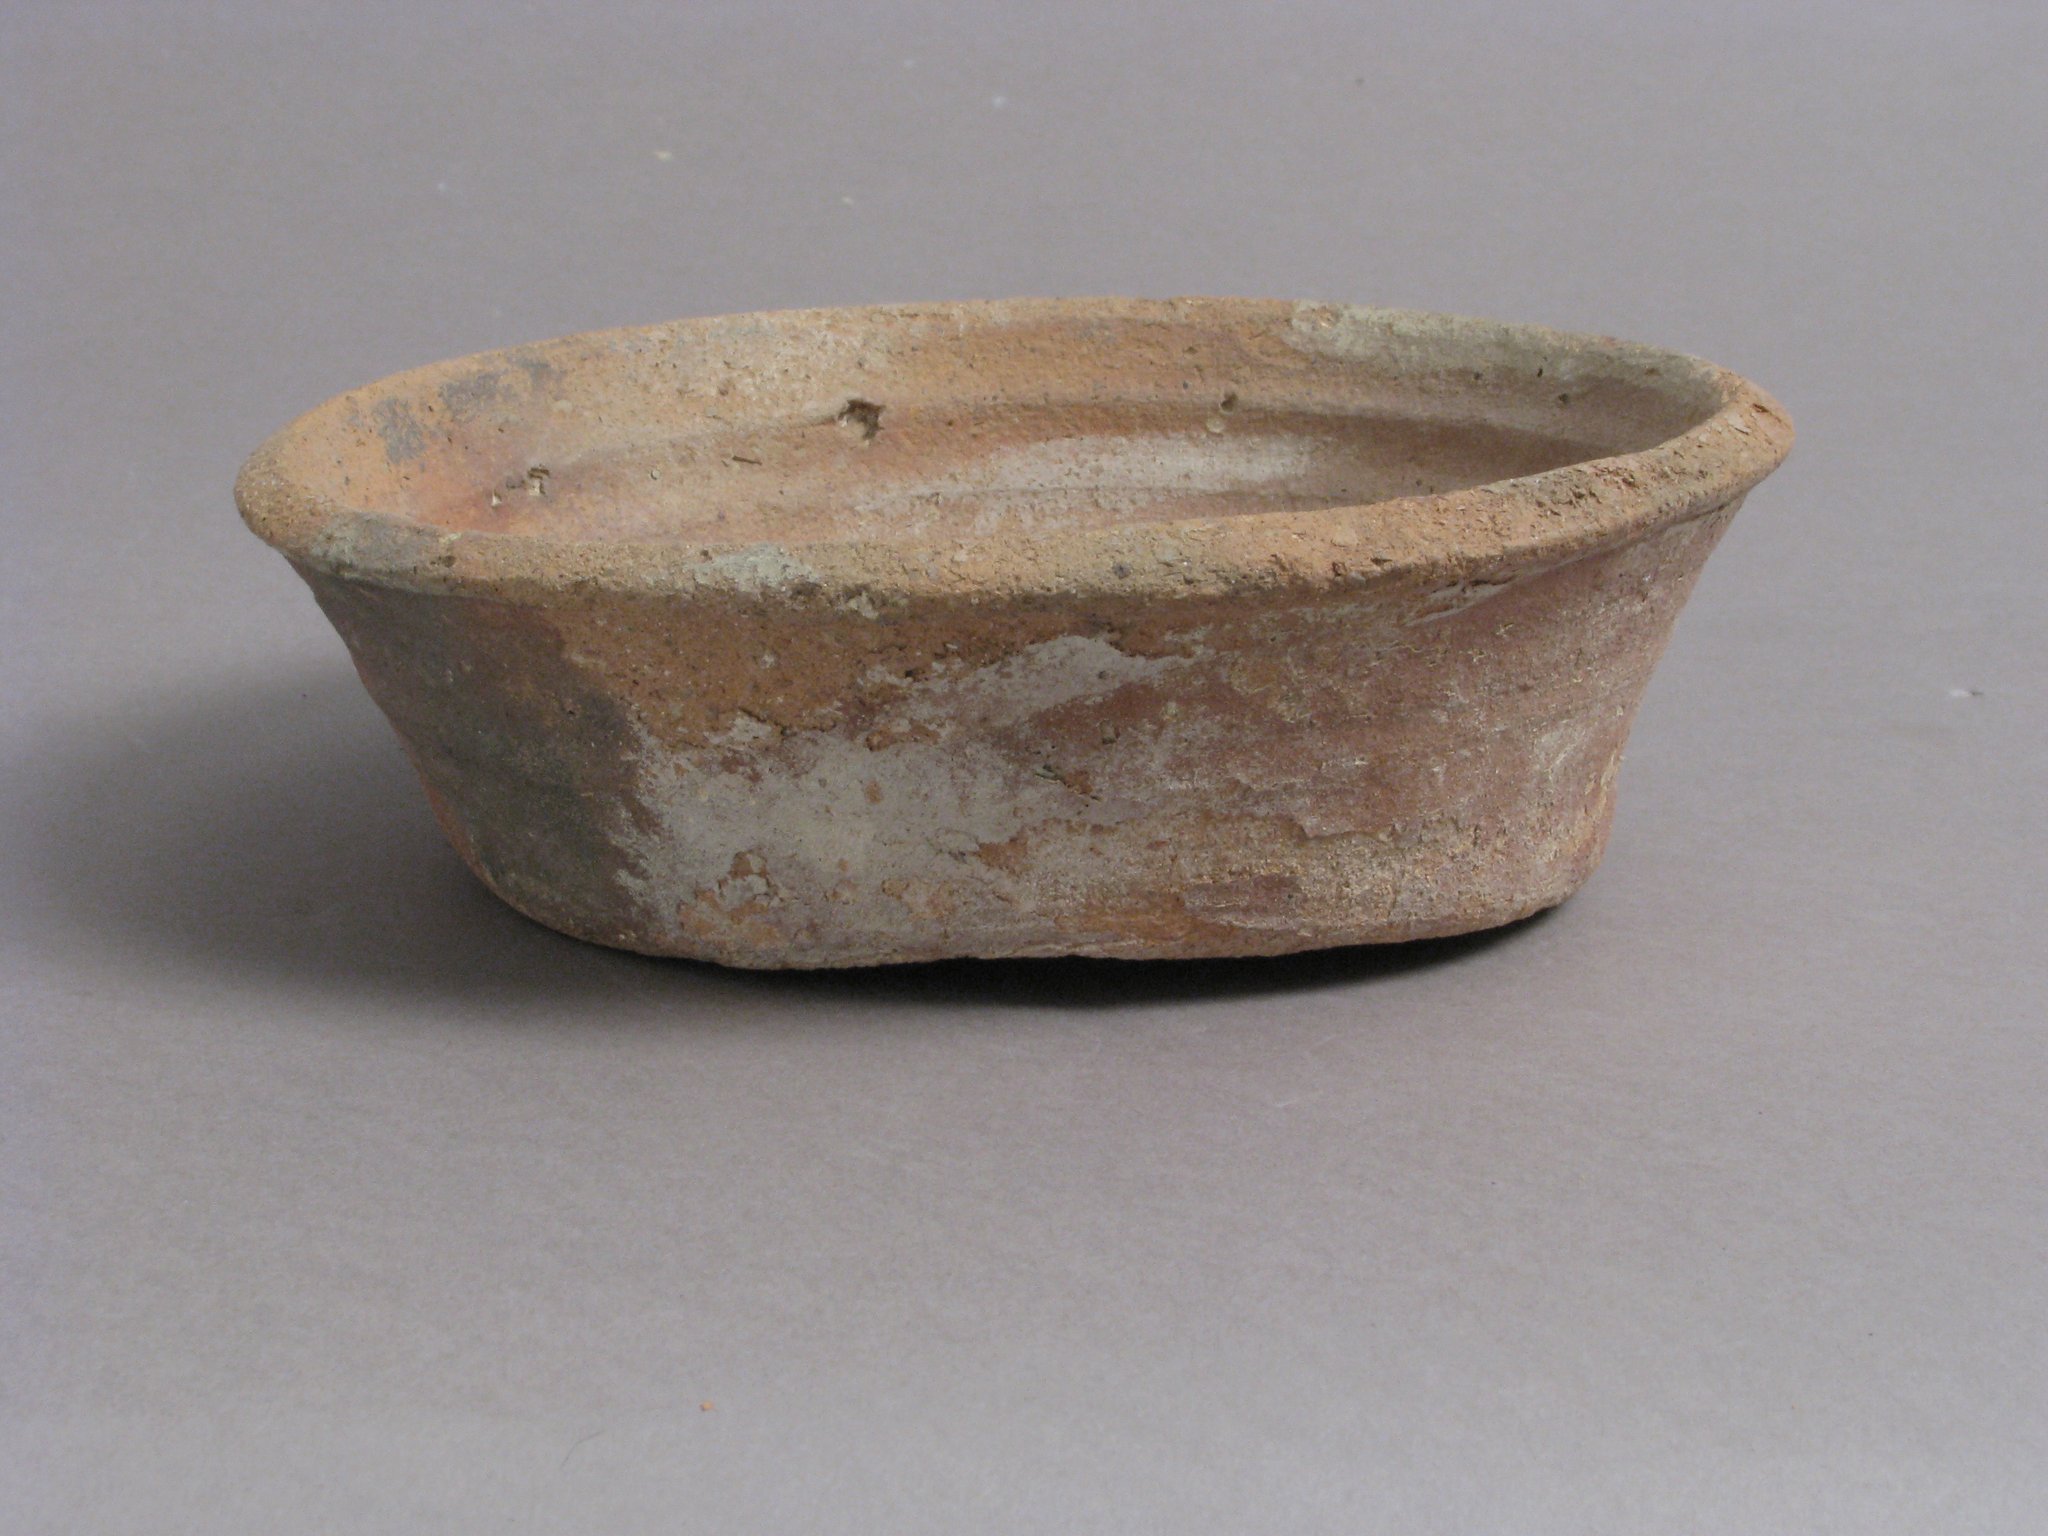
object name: bowl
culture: coptic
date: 301-700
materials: earthenware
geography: egypt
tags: bowls